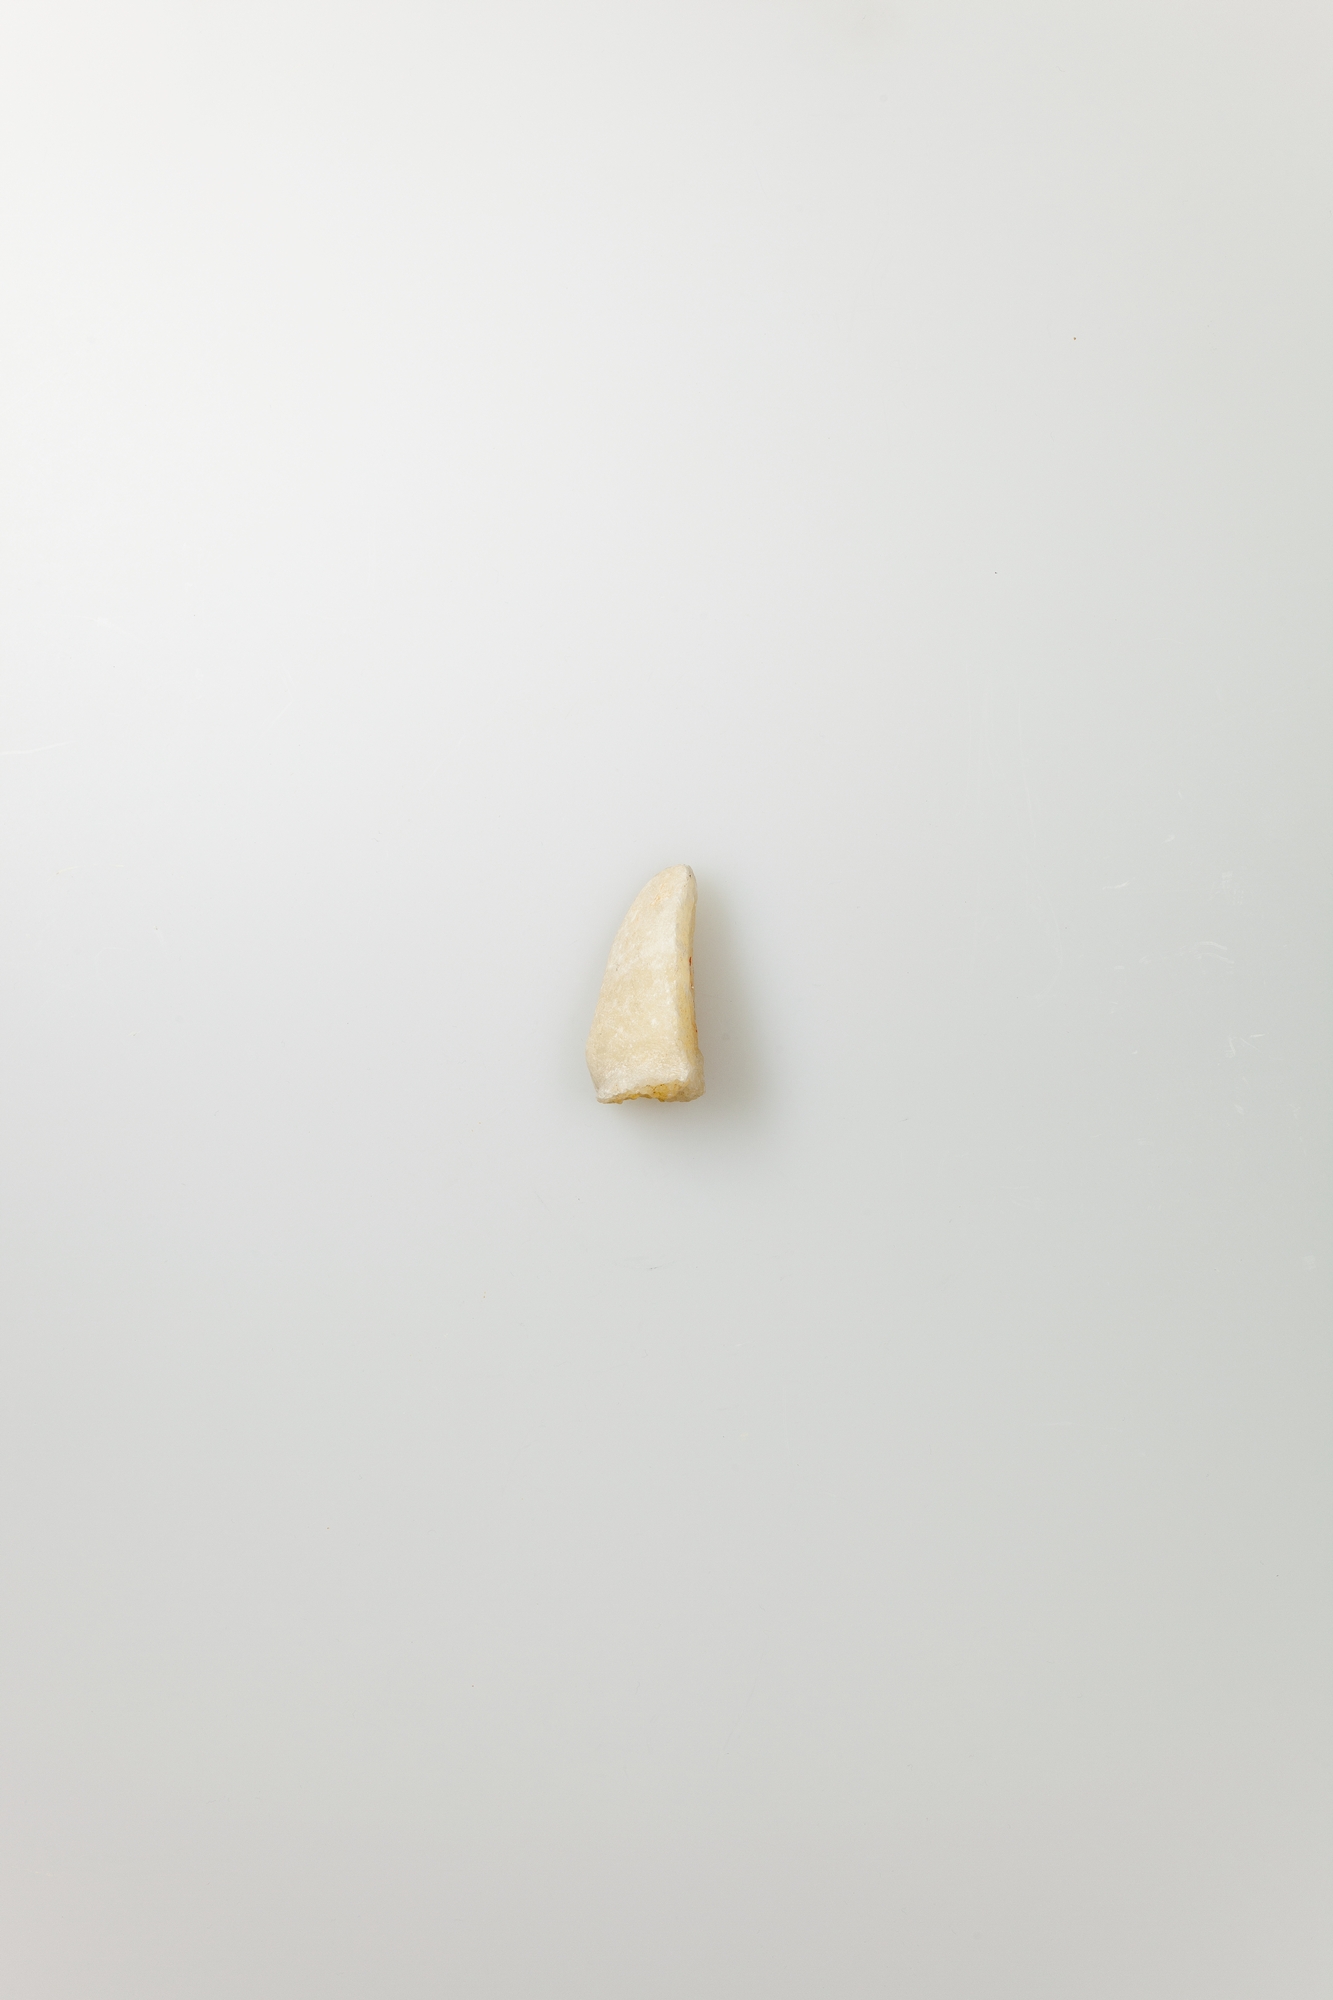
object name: shabti, siptah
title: Shabti of Siptah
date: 1194-1188 BCE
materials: stone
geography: egypt